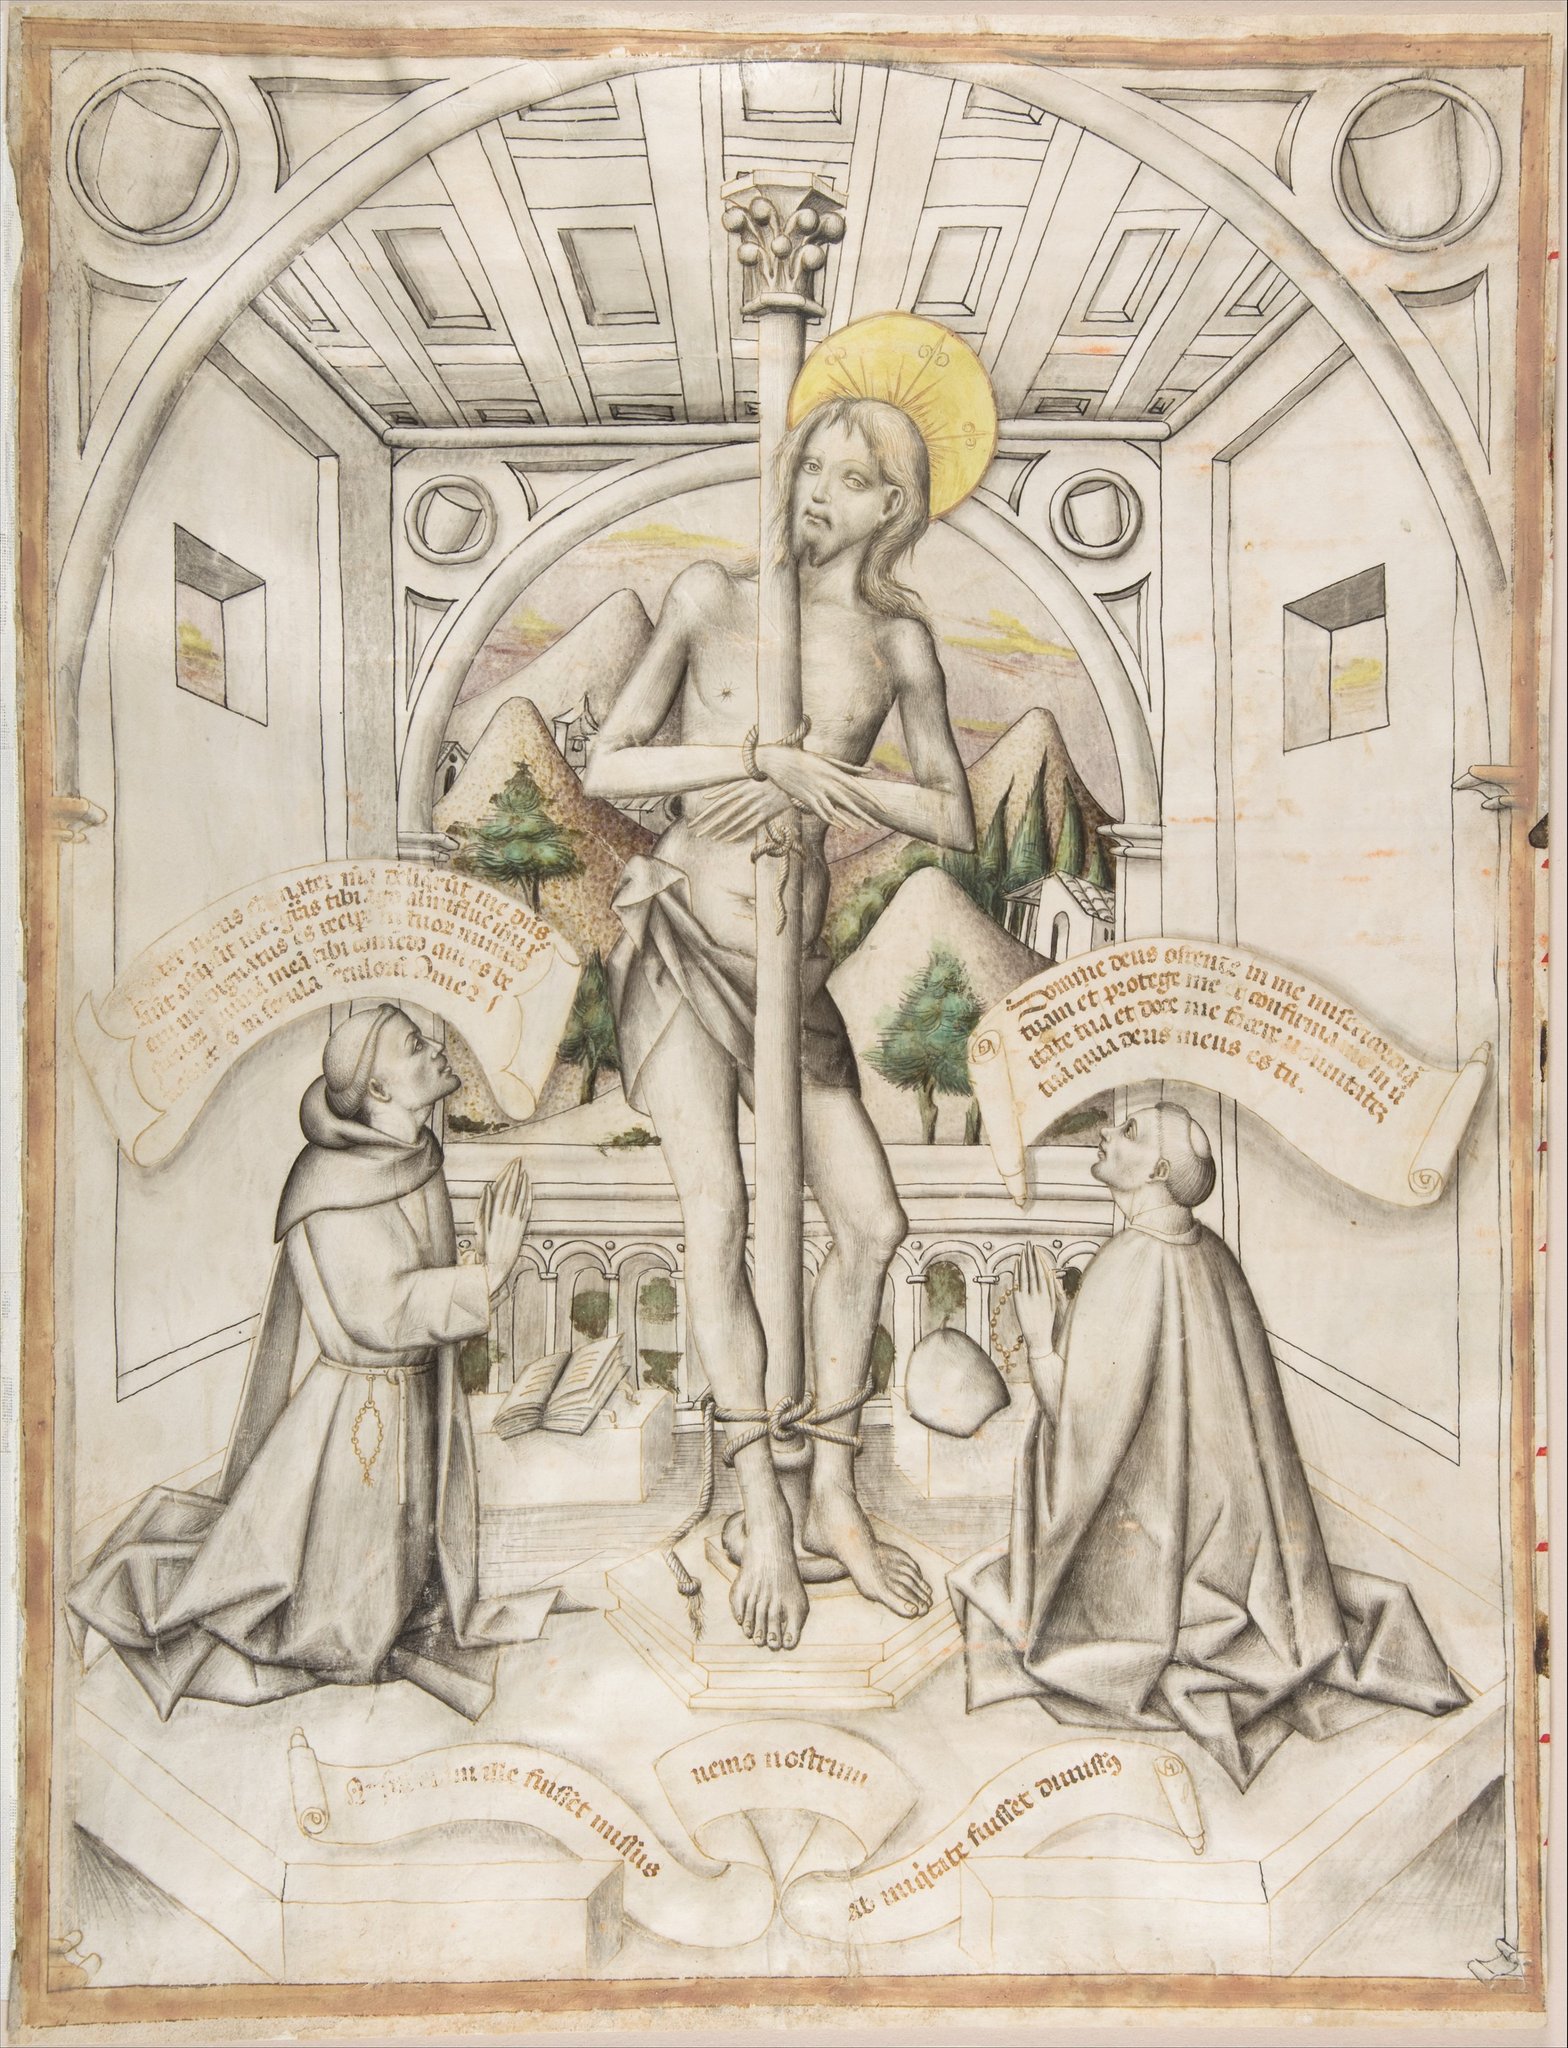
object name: drawing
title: Christ at the Column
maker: delli brothers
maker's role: artist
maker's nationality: italian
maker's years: 1430-1469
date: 1440-1470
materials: gouache, ink, parchment, watercolor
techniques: brush, pen, wash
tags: columns,men,christ